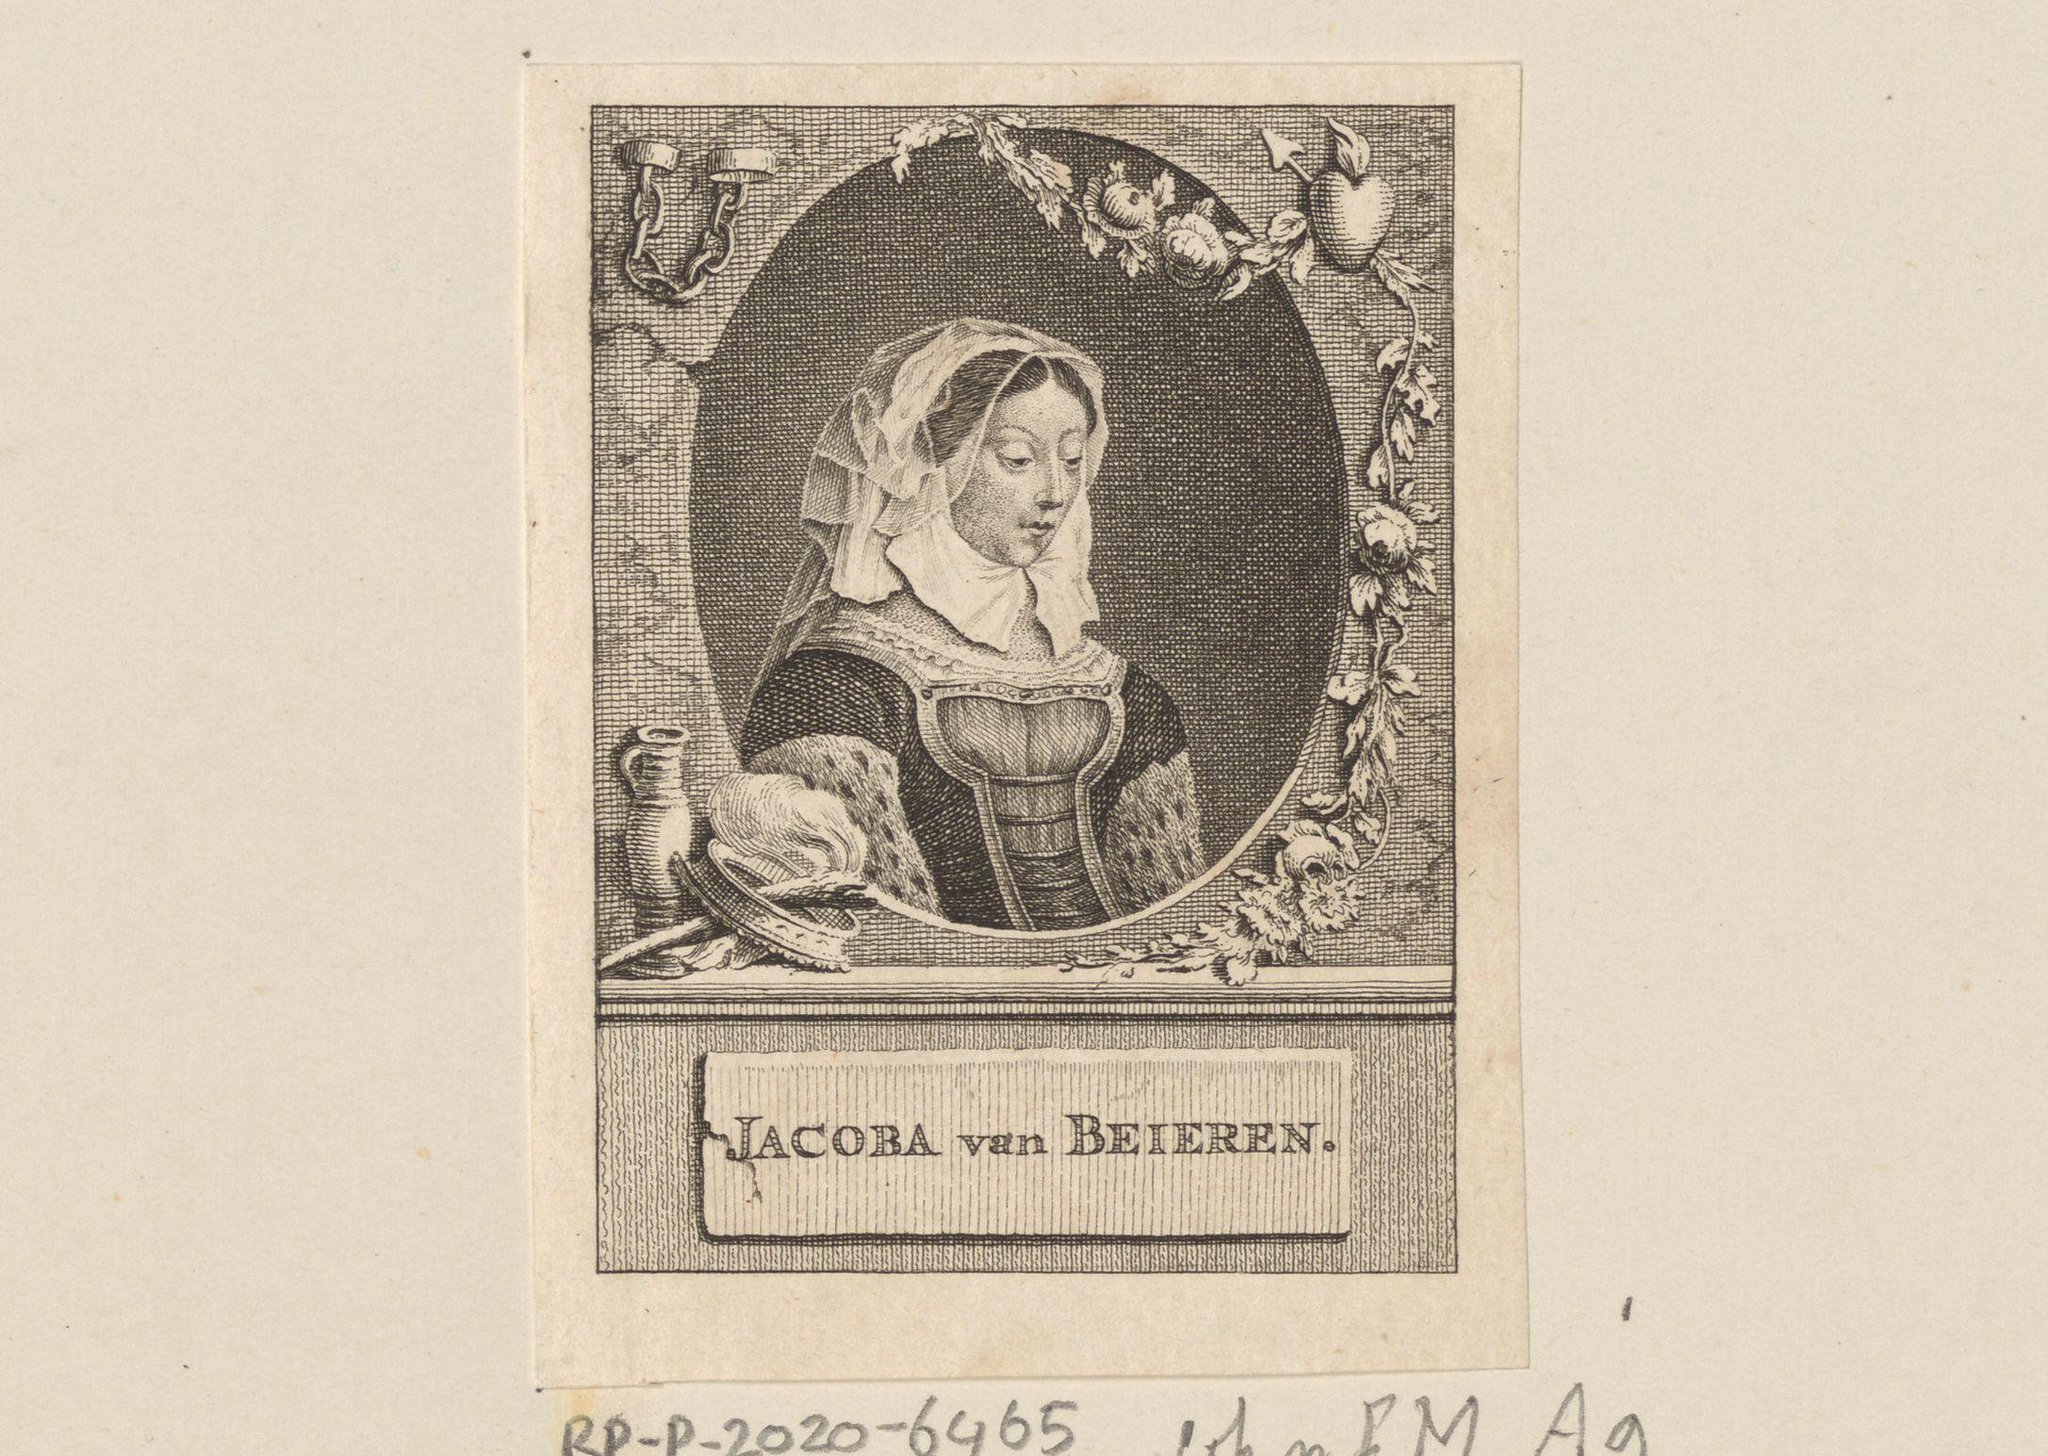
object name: print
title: Portret van Jacoba van Beieren, gravin van Holland, Zeeland en Henegouwen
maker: Anonymous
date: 1750-1799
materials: paper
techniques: etching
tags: jacoba of bavaria (countess of hainaut), historical persons - bb - woman, the sacred heart, ruler, sovereign - bb - female ruler, tools, aids, implements ~ crafts and industries: chain